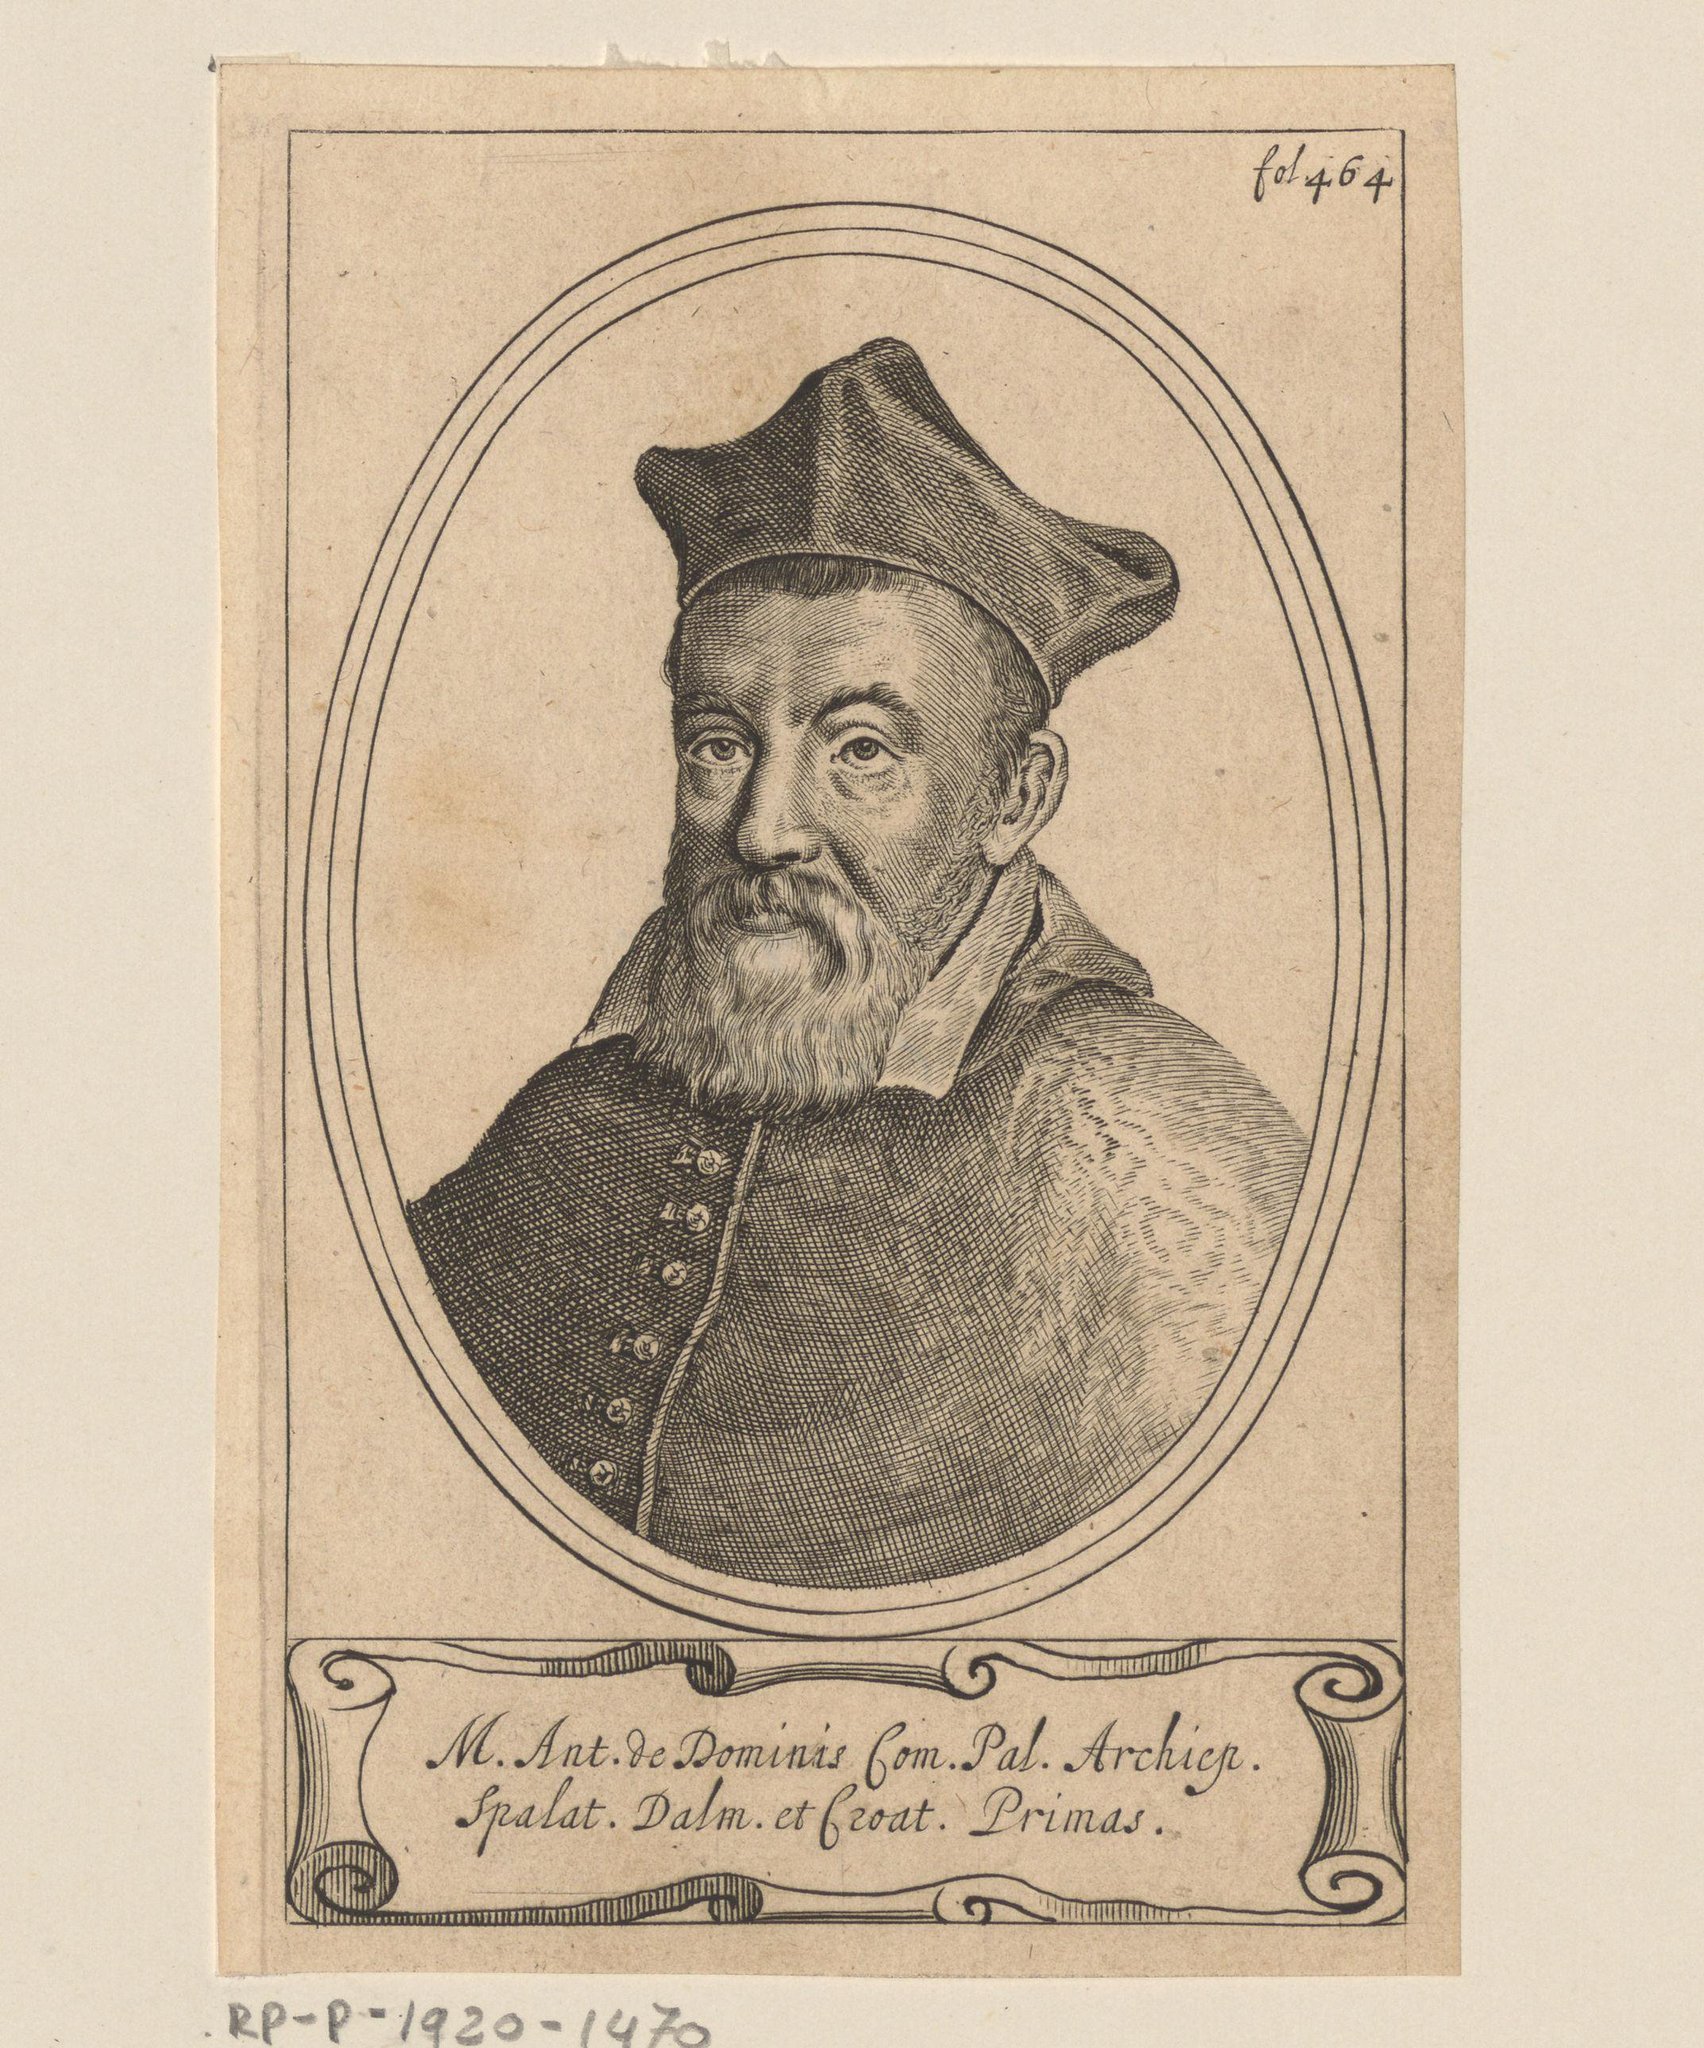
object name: print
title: Portret van Marcus Antonius De Dominis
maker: Anonymous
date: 1650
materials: paper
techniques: engraving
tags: rome, scholar, philosopher, historical persons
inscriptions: collector's mark: Lugt 2228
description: Andere staat van prent gebruikt in: Bos, Lambert van den. Het treur-toonneel der doorluchtige mannen onser eeuwe (...). Amsterdam: Nicolaas van Ravesteijn, 1650, dl. 1, fol. 338.